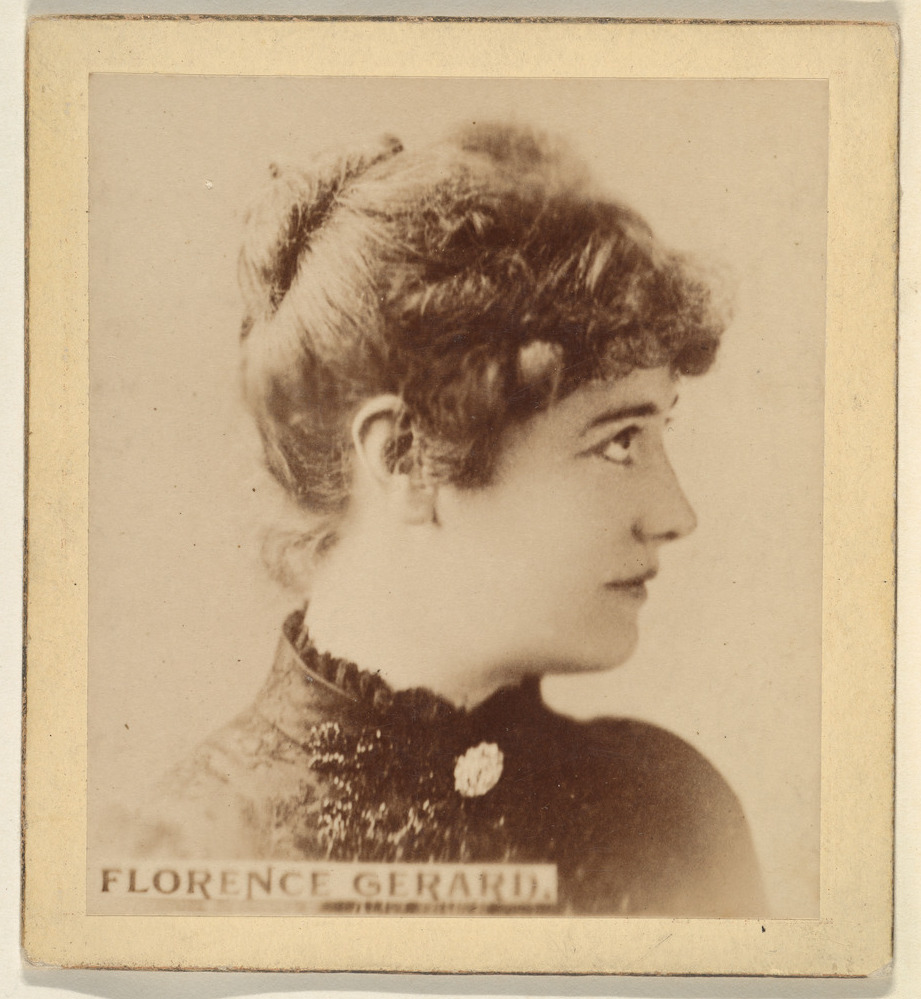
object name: photograph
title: Florence Gerard, from the Actresses series (N246), Type 2, issued by Kinney Brothers to promote Sporting Extra Cigarettes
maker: kinney brothers tobacco company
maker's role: publisher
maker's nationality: american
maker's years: 1869-2011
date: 1890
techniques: albumen silver print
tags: women,actresses